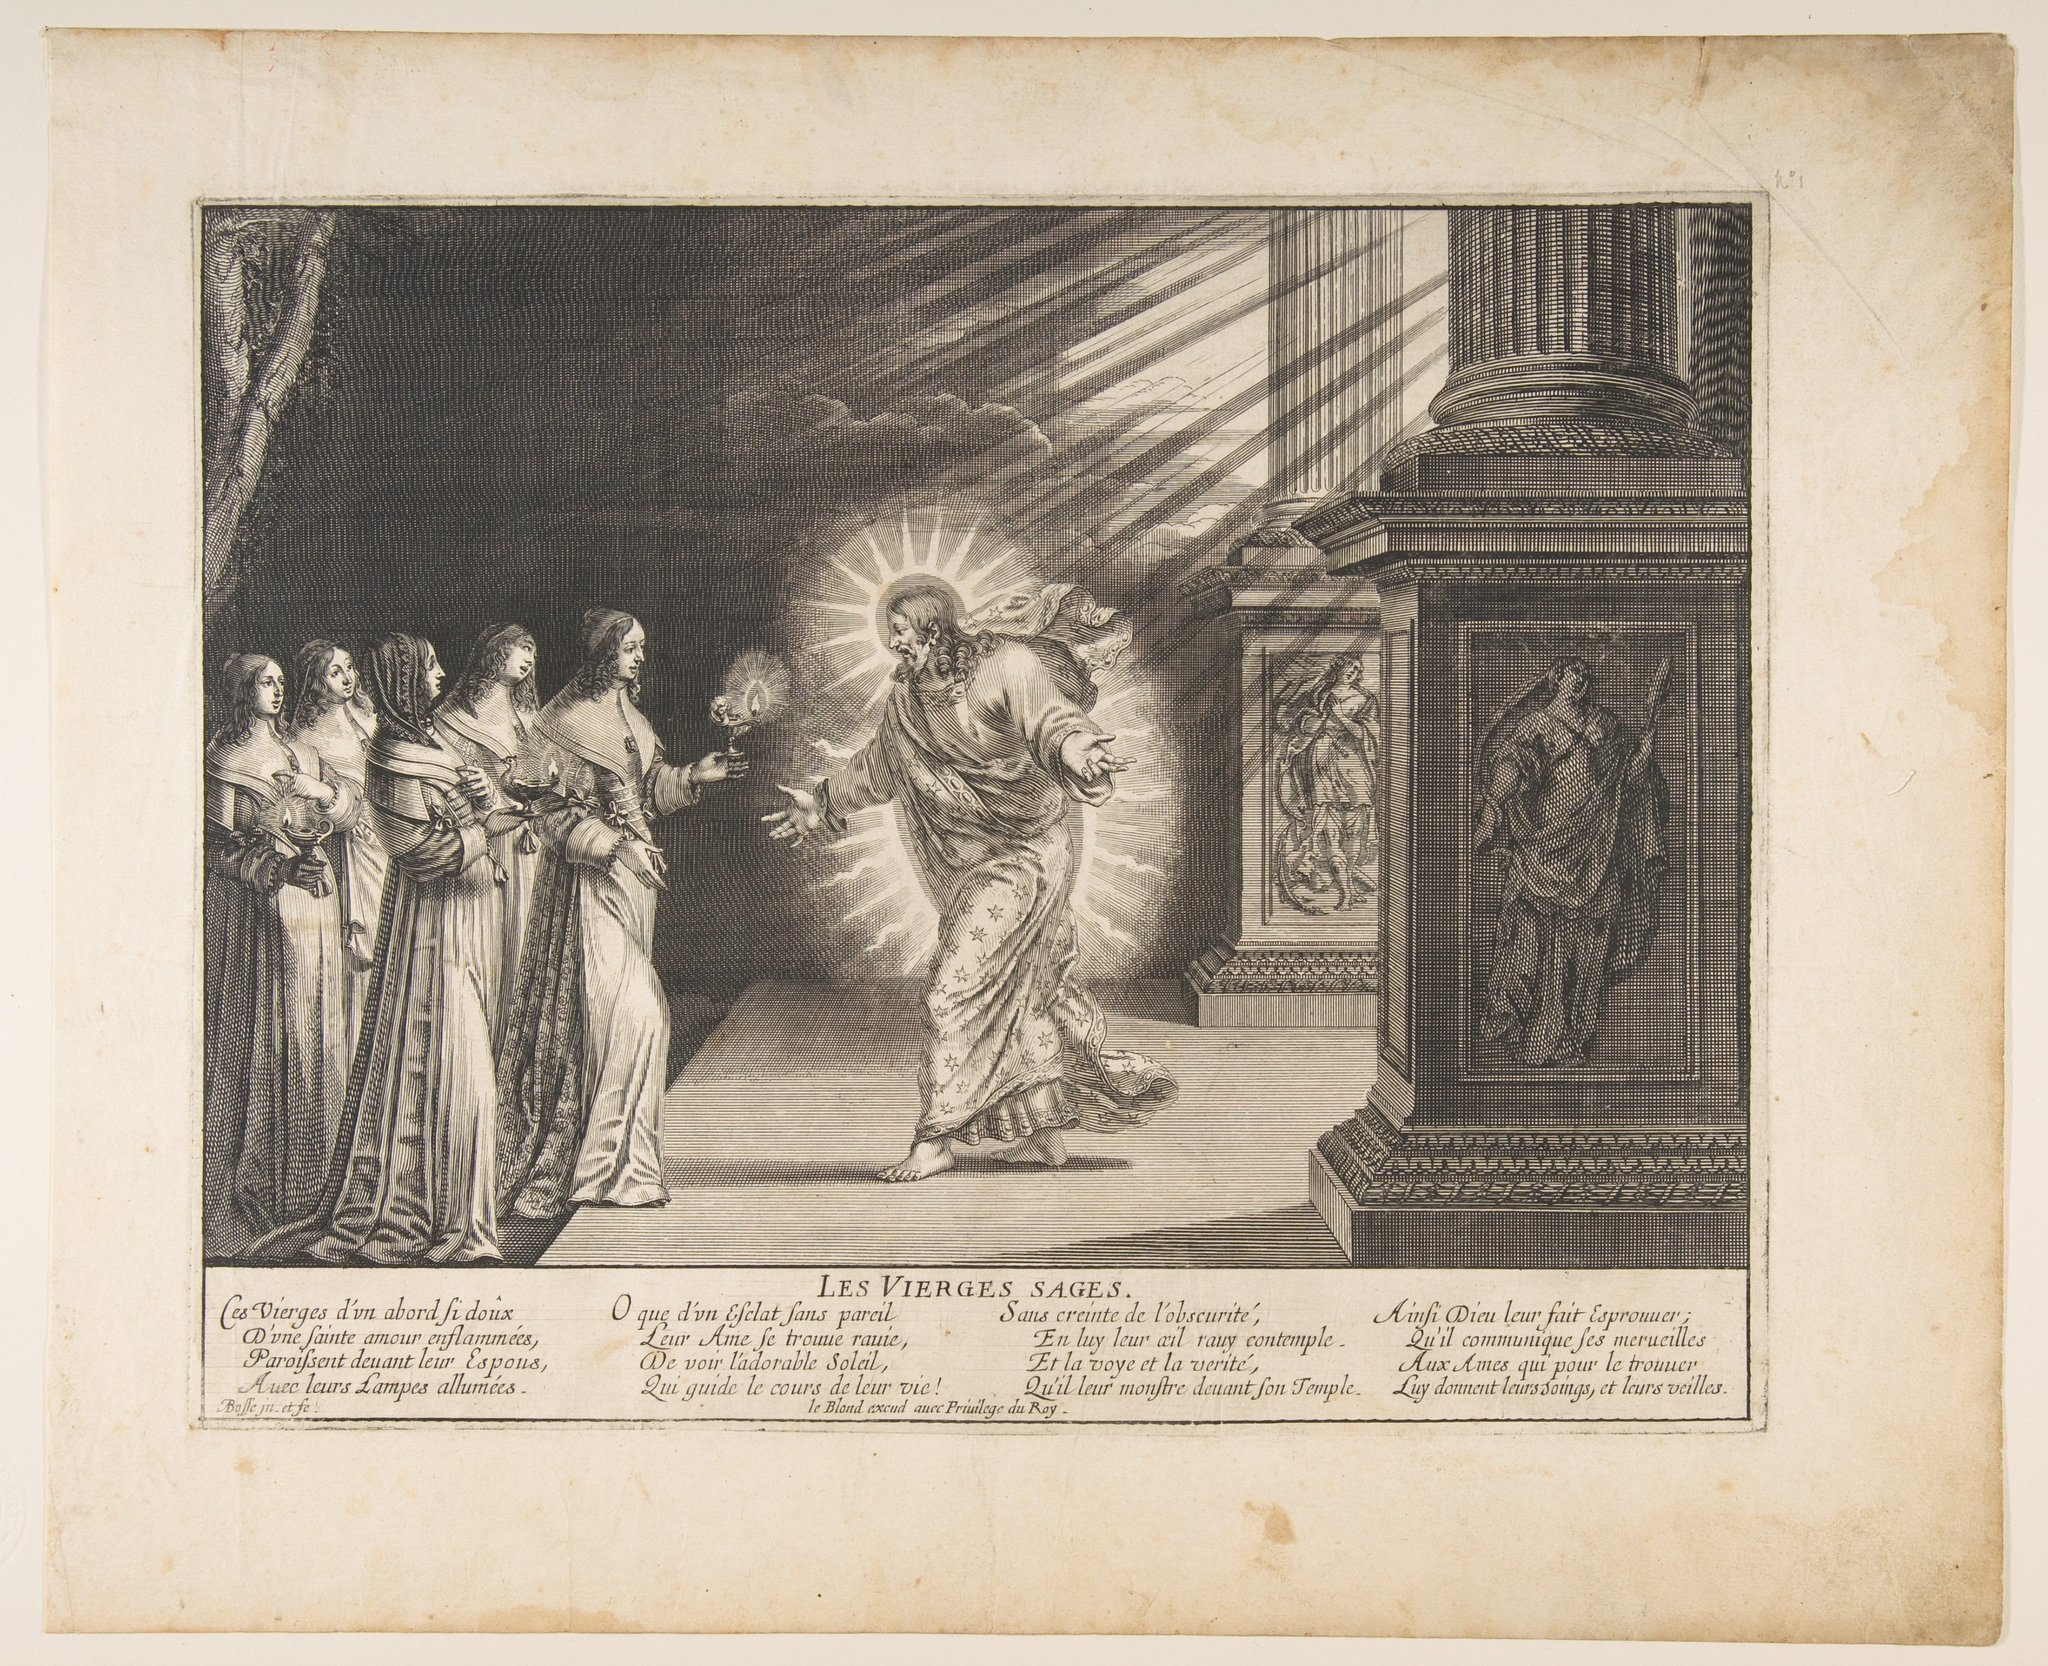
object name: print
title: The Wise Virgins before Christ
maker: abraham bosse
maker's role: artist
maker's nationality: french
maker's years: 1602-1676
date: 1635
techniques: engraving, etching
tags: women,christ,virgin mary